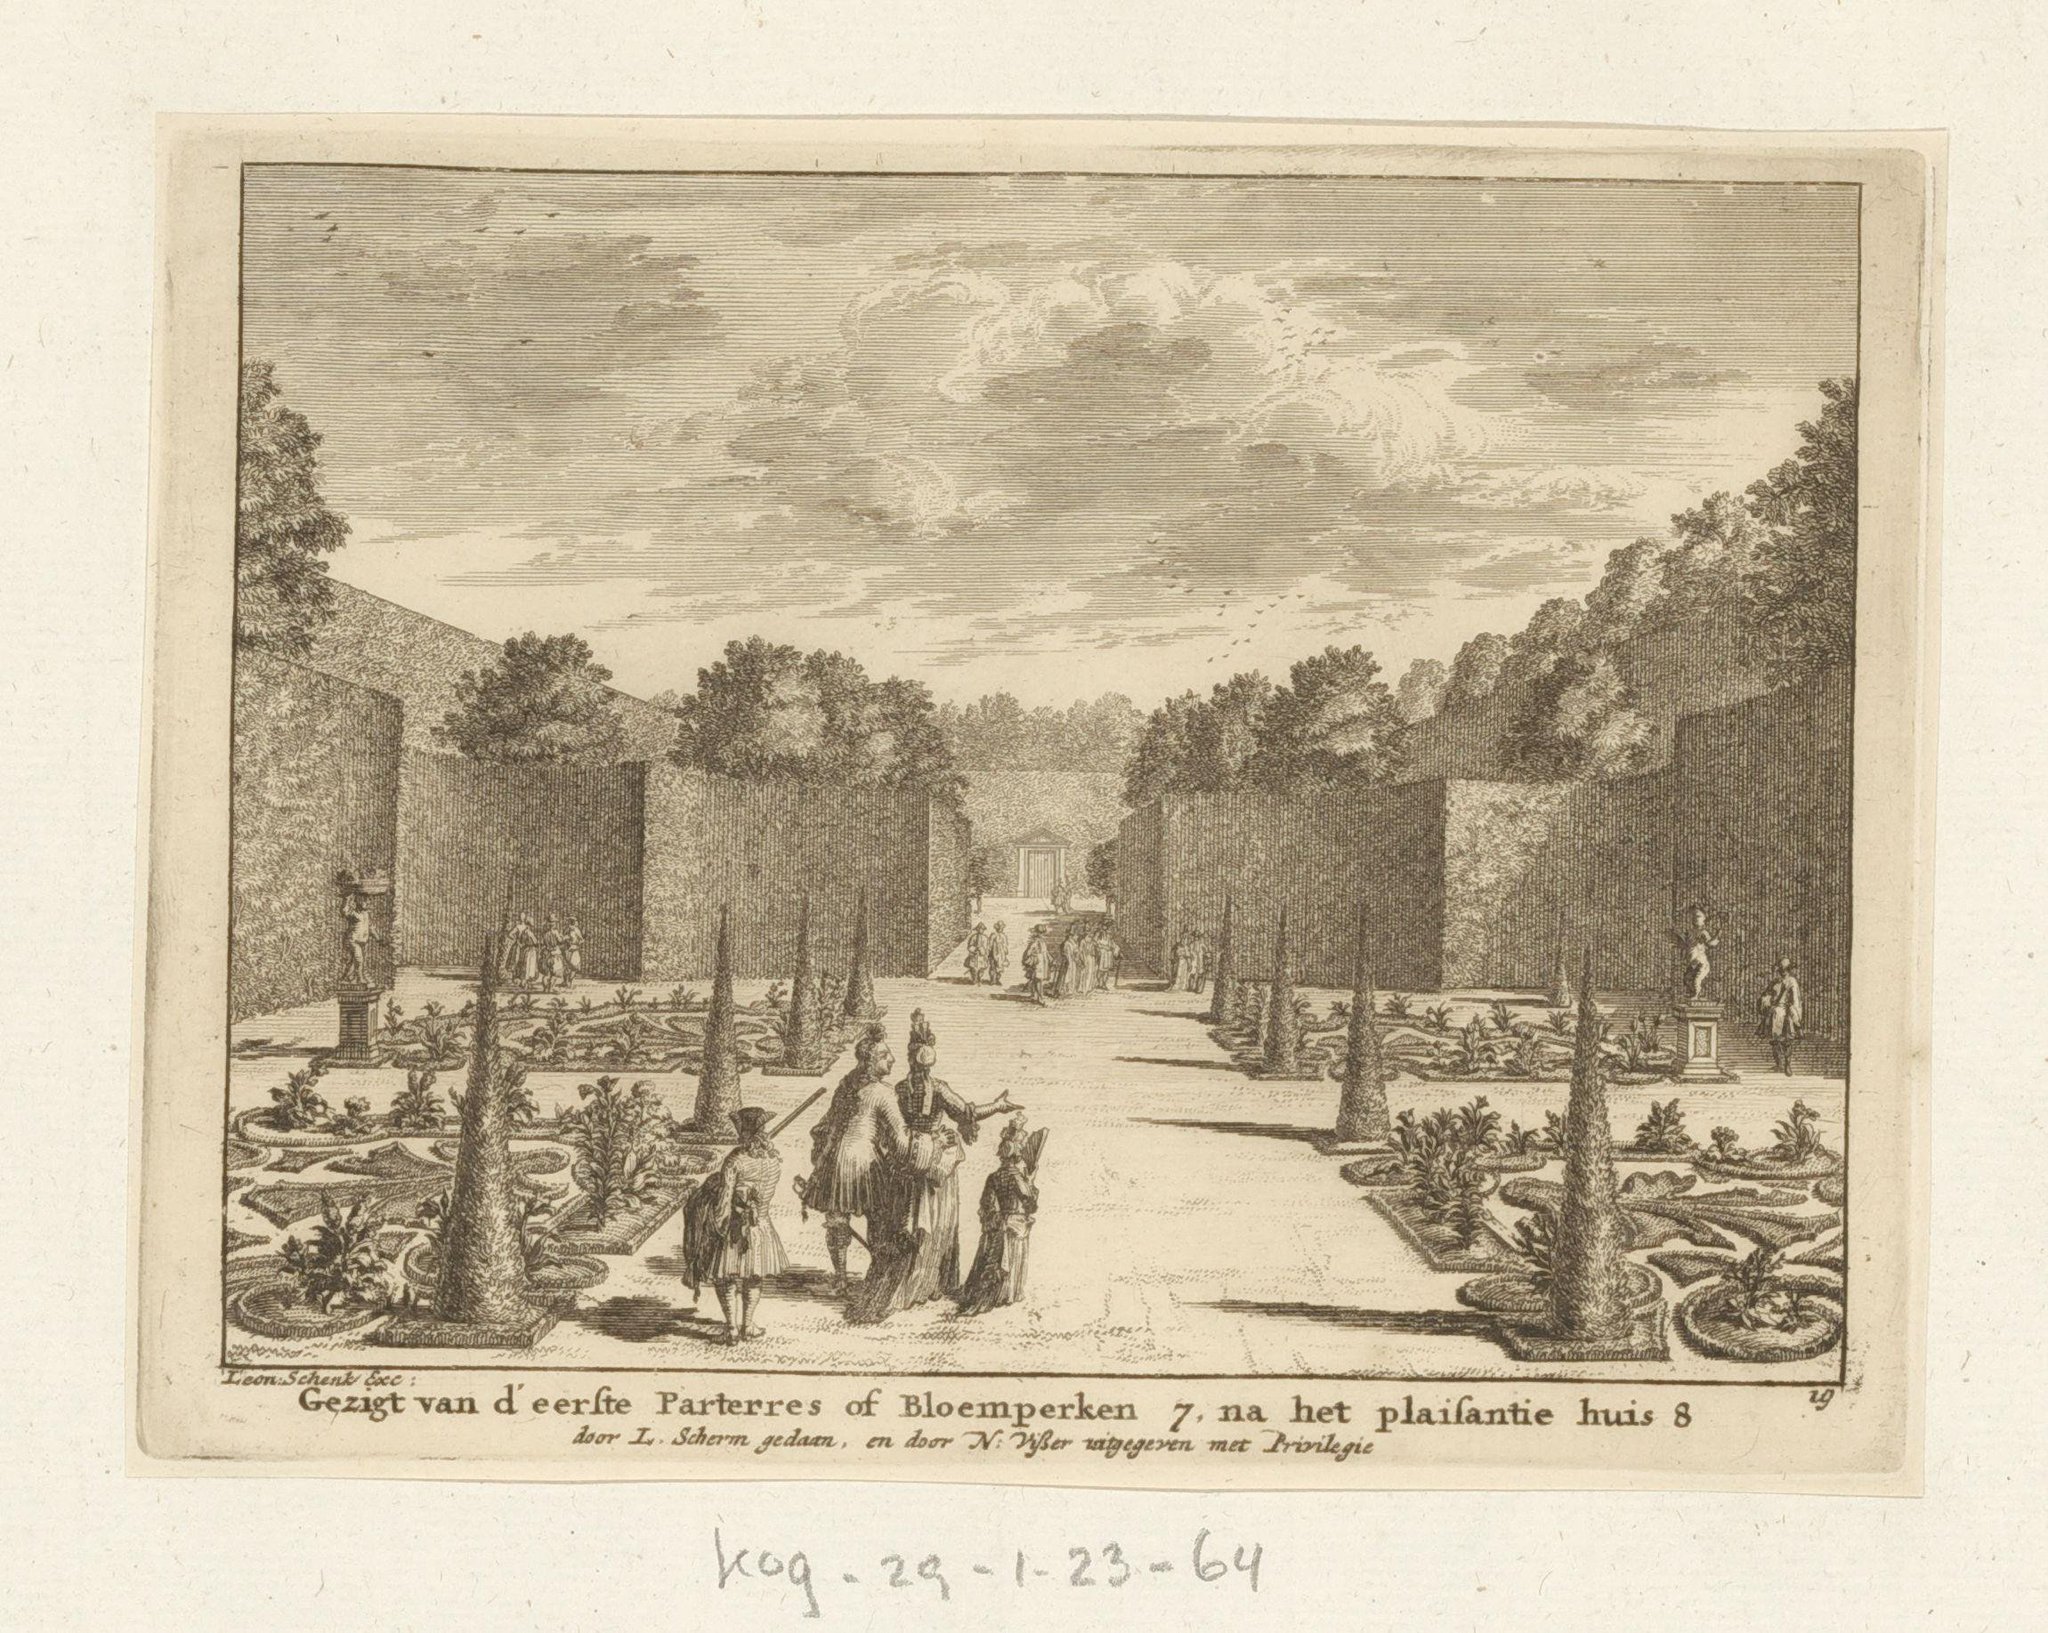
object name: print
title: Gezigt van d'eerste Parterres of Bloemperken na het plaisantie huis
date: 1706-1767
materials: paper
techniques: engraving, etching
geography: amsterdam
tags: french or architectonic garden; formal garden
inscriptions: stamp, stamp, collector's mark: Lugt 1641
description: Gezicht op de eerste bloemperken omringd door hagen op landgoed Clingendael te Den Haag. Op de voorgrond een elegant gezelschap. Onderwerpsrubrieken binnen de Atlas Zeden en Gewoonten: Zeden en Gewoonten in Engeren Zin, De Woning. Kastelen en buitenplaatsen. Holland.